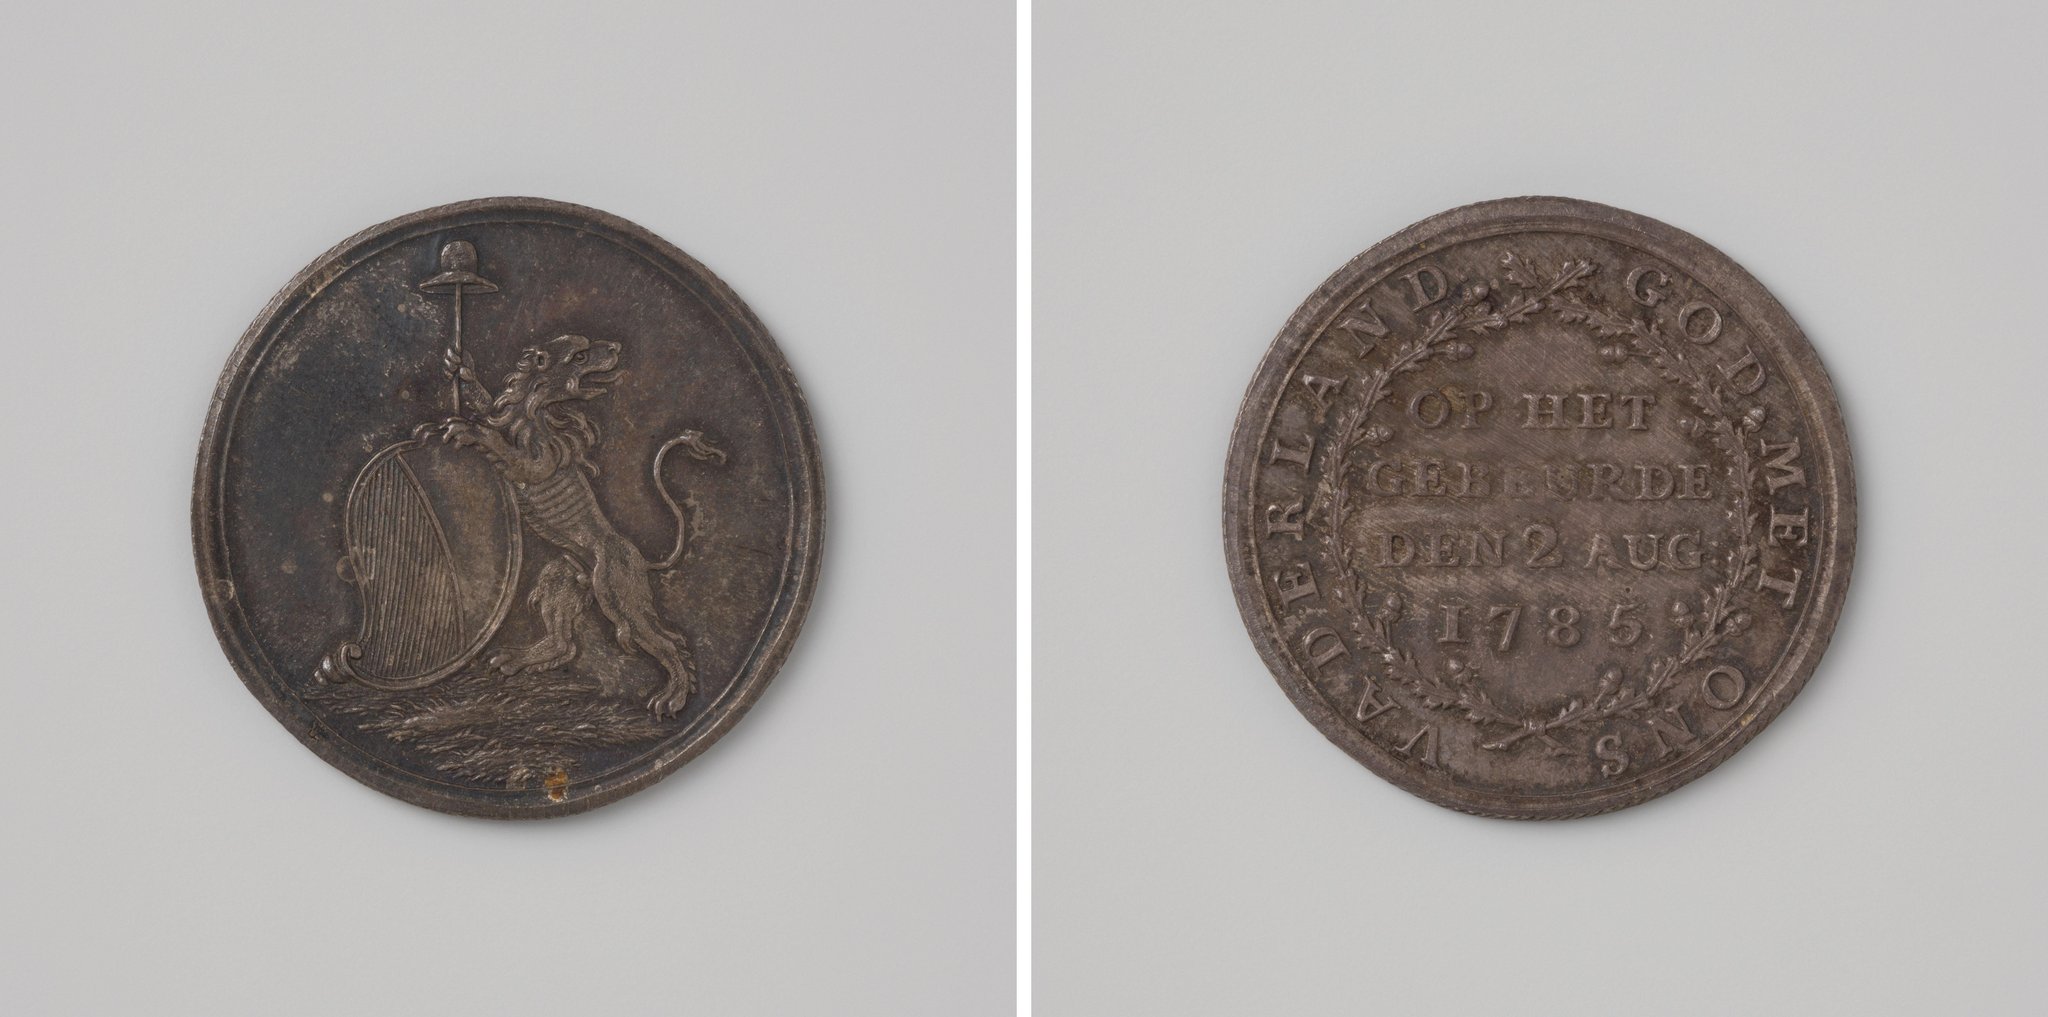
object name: history medal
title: Erkenning van de gecommitteerden der acht burgercorpsen te Utrecht door burgemeester en vroedschap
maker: Anonymous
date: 1785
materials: silver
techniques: striking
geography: netherlands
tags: utrecht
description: Zilveren penning. Voorzijde: leeuw met vrijheidshoed op speer en wapenschild. Keerzijde: opschrift binnen eikenkrans en omschrift